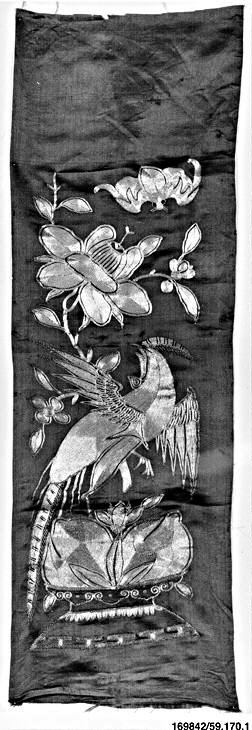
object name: sleeve band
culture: chinese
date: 1867-1900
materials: metal thread, silk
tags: birds,insects,flowers